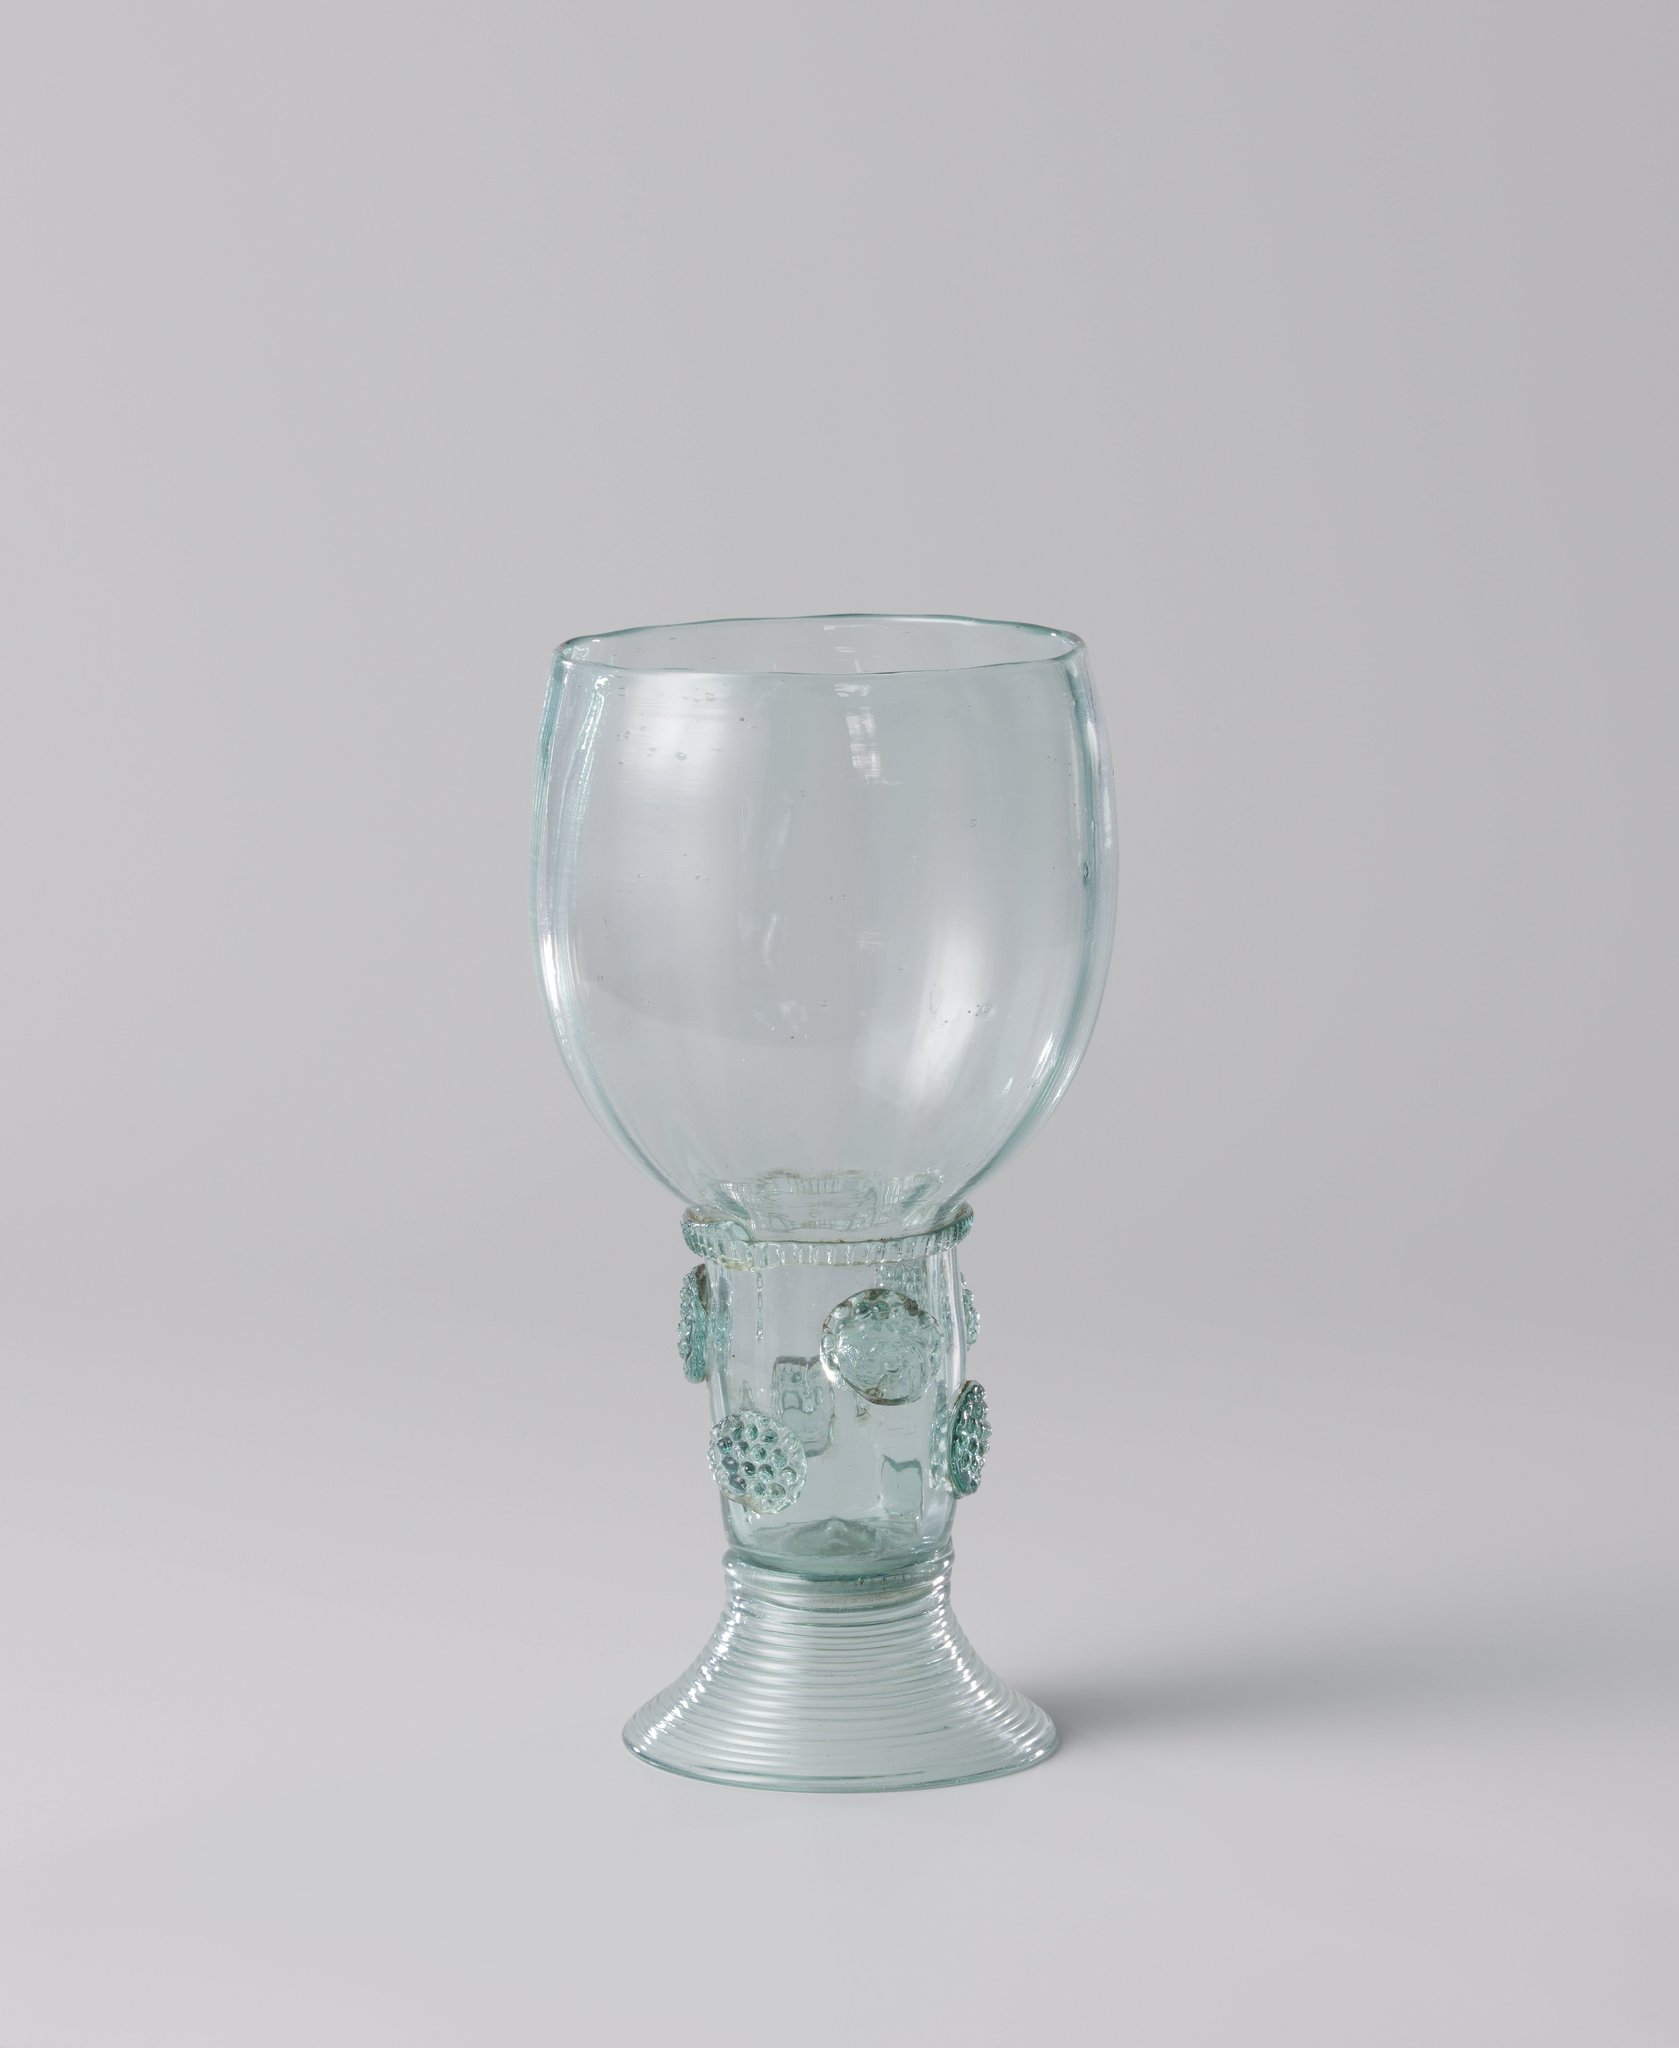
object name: roemer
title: Roemer met twee rijen braamnoppen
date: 1700-1900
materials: glass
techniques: glassblowing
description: Roemer met ingestoken bodem op concave, uit een draad gesponnen voet. De eivormige kelk met lichte ribben, als één geheel geblazen met de stam die bezet is met twee rijen braamnoppen. De overgang van de kelk naar de stam wordt aangegeven door een geribde draad.